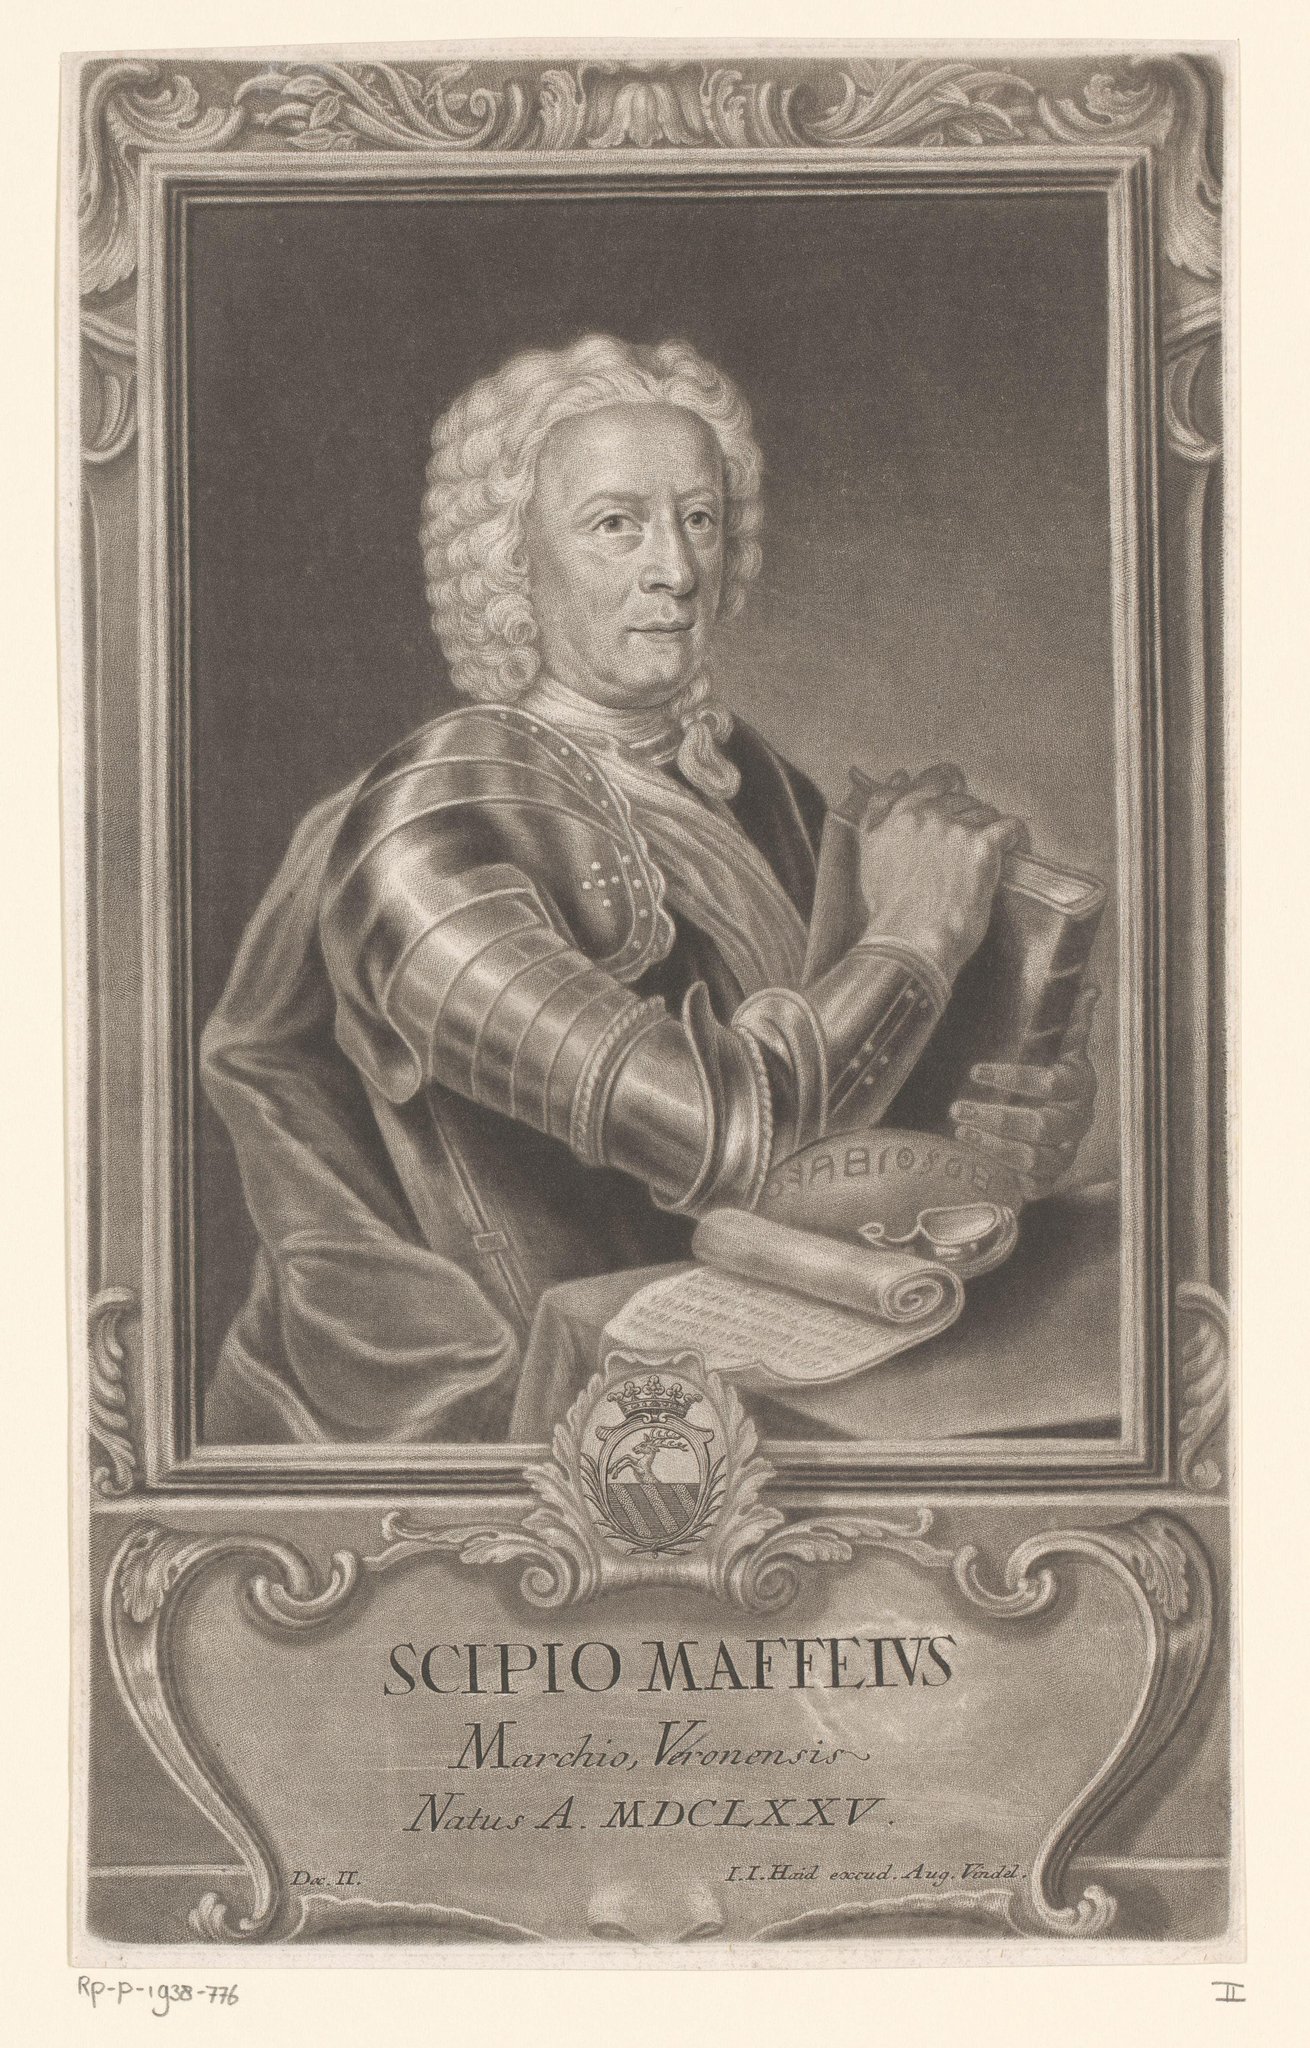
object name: print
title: Portret van Scipione Maffei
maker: johann jacob haid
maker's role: print maker, publisher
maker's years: 1704-1767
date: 1742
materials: paper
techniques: etching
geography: augsburg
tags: inscription, armour, historical persons, oil-lamp, ornament ~ cartouche, armorial bearing, heraldry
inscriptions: collector's mark: Lugt 2228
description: Prent gebruikt voor: Brucker, Jacob. Bildersal heutiges Tages lebender und durch Gelahrheit berühmter Schrifftsteller. Augsburg: Johann Jacob Haid, 1742.